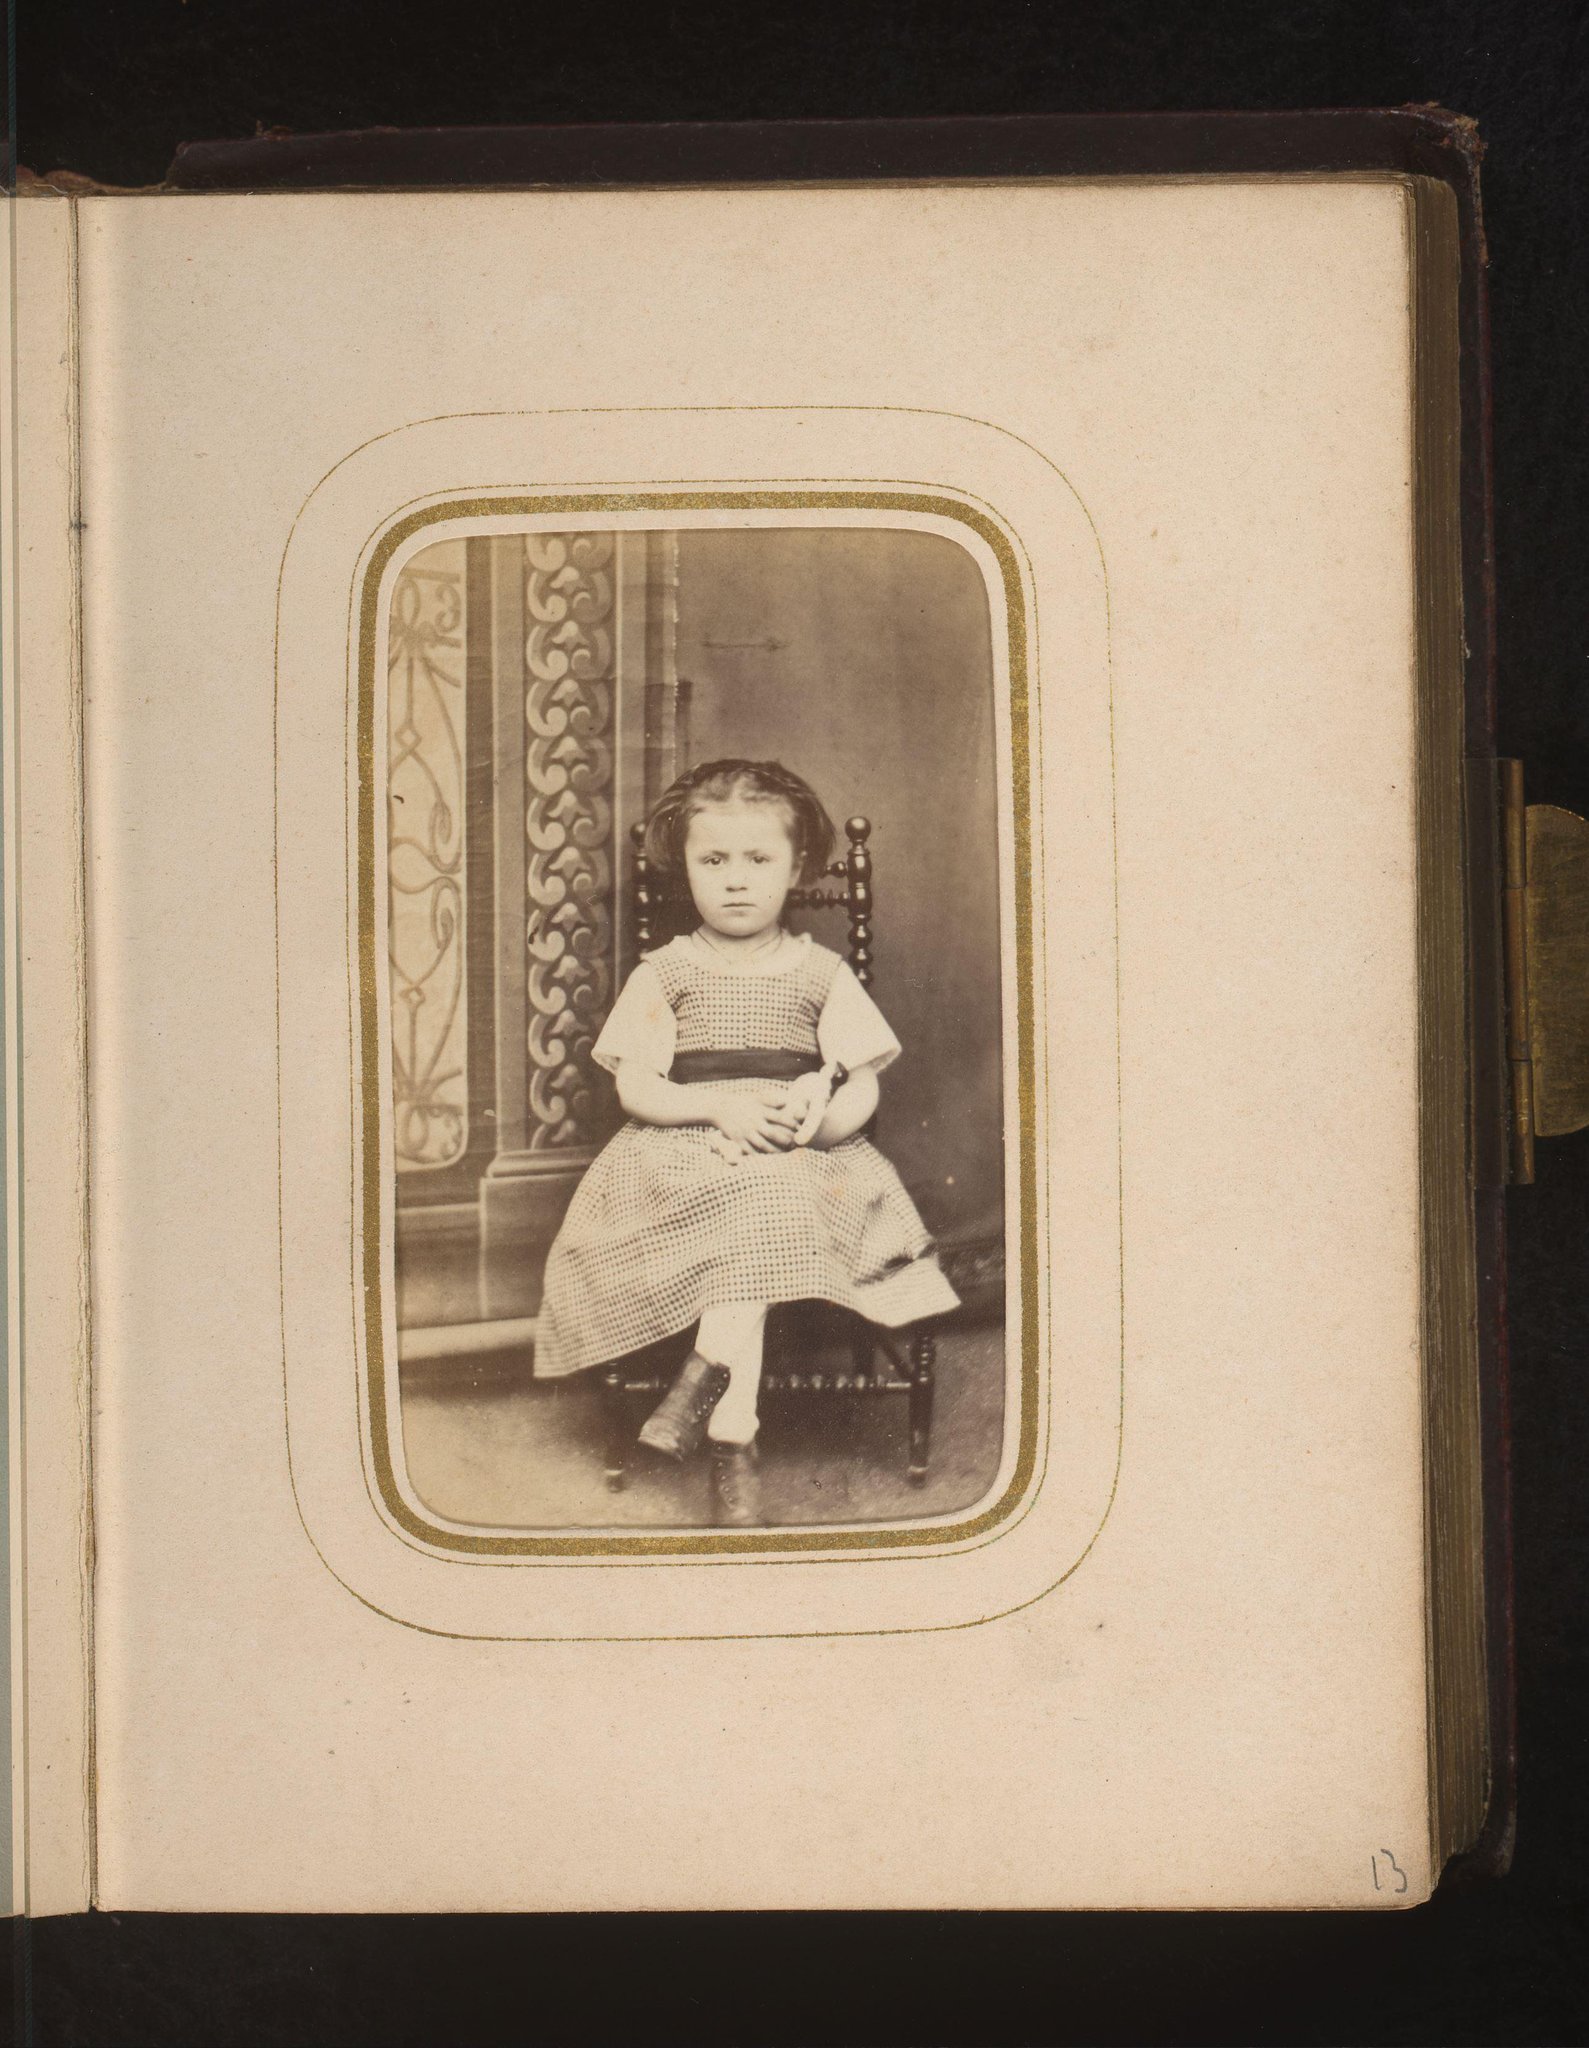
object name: album leaf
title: Portret van een meisje, zittend op een stoel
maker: Anonymous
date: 1860-1900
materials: cardboard, photographic support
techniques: albumen print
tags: girl (child between toddler and youth)